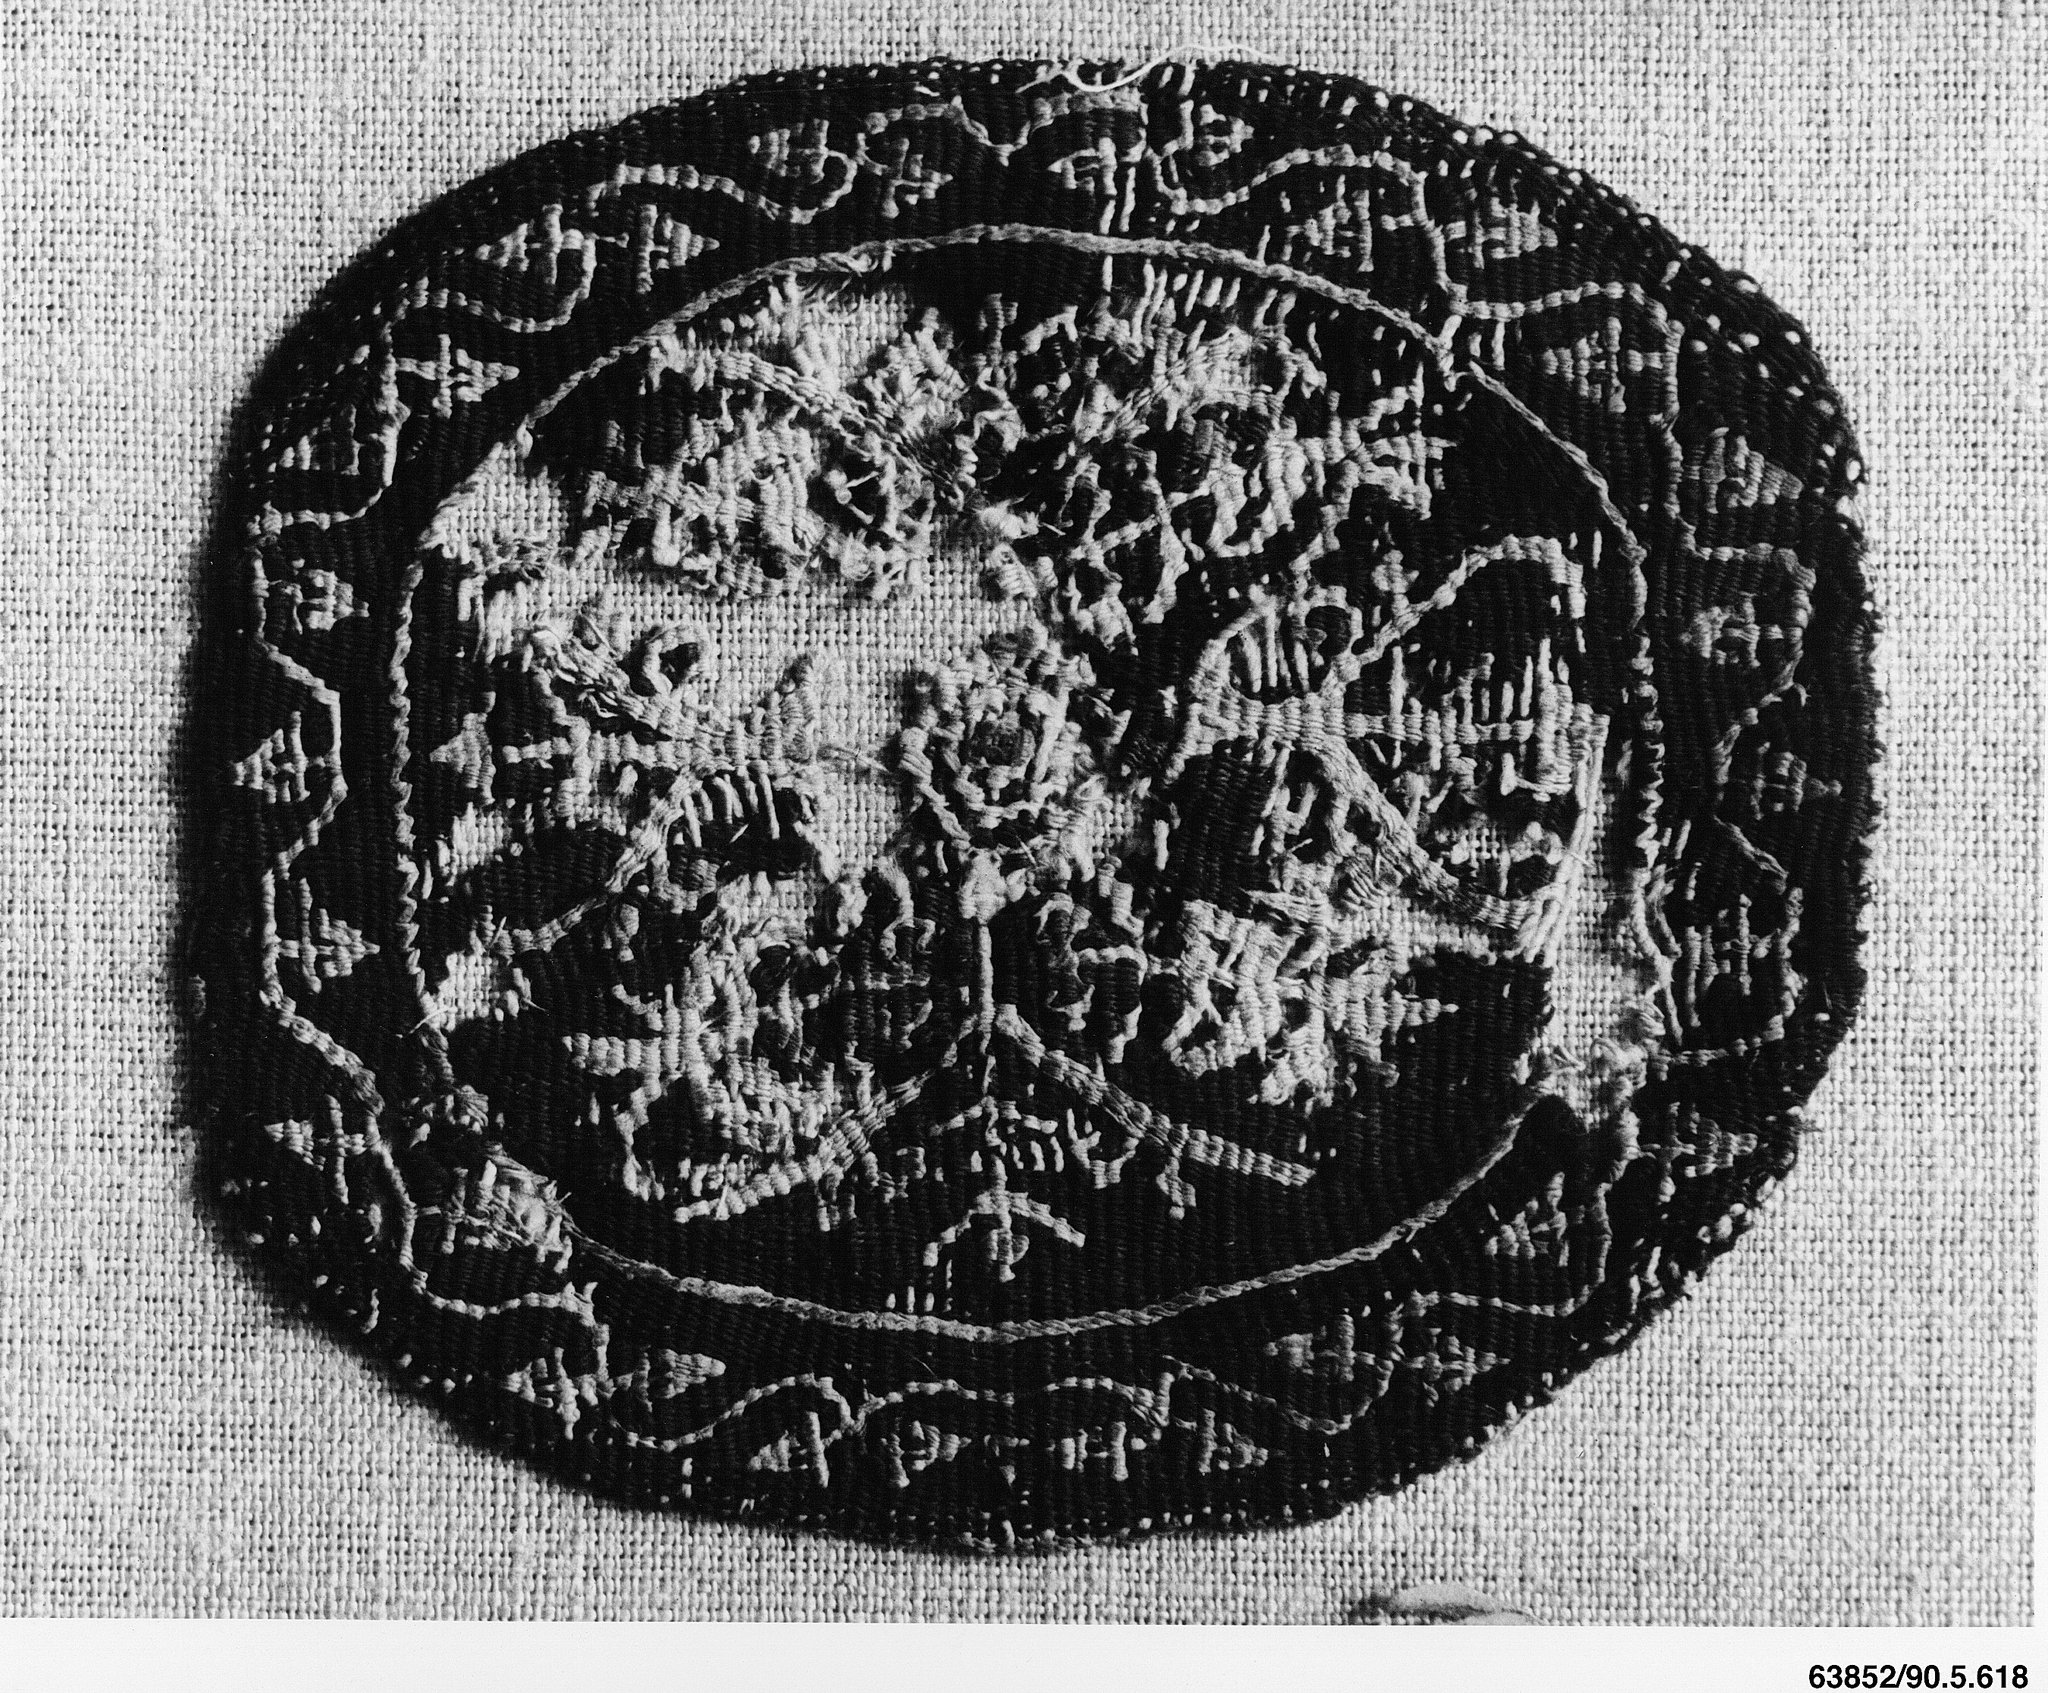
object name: textile fragment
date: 301-400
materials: linen, wool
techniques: weave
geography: egypt